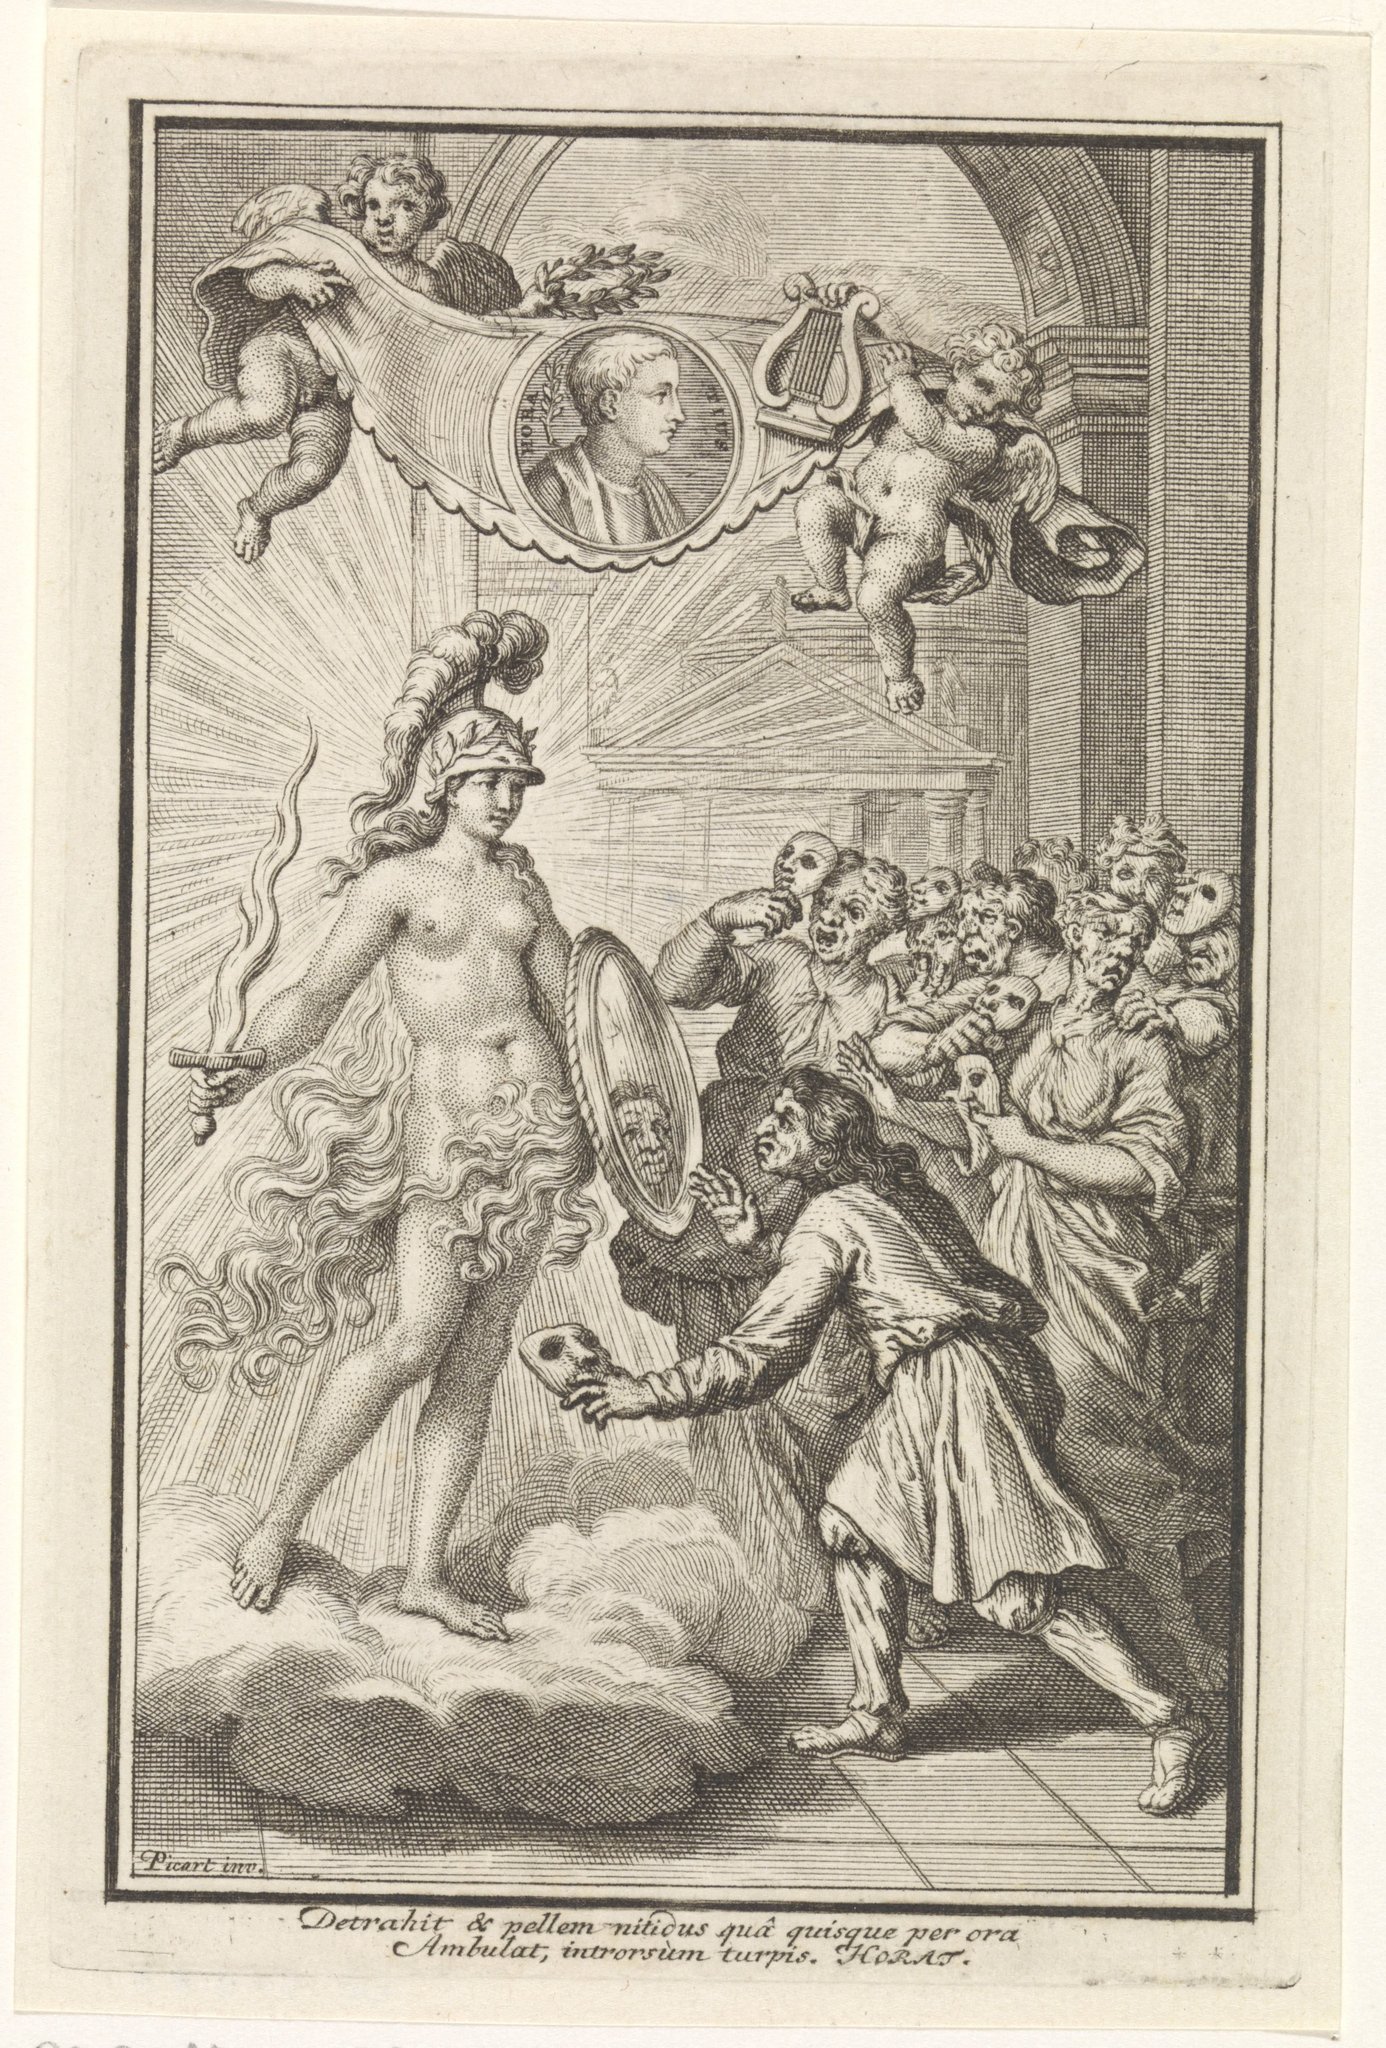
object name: print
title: Allegorische voorstelling met Waarheid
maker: bernard picart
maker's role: draughtsman, print maker, publisher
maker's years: 1673-1733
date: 1713-1733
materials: paper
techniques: engraving, etching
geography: amsterdam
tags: venosa, horatius, mask, group of actors, troupe; actors on the stage, truth; 'verità' (ripa)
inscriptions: collector's mark: Lugt 2228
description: De personificatie van waarheid, een naakte vrouw met een vlammend zwaard in de hand, houdt een aantal toneelspelers met maskers in de hand een spiegel voor. In de lucht twee putti met een banderol waarop het portret van Horatius. In de marge een tweeregelig onderschrift in het Latijn.